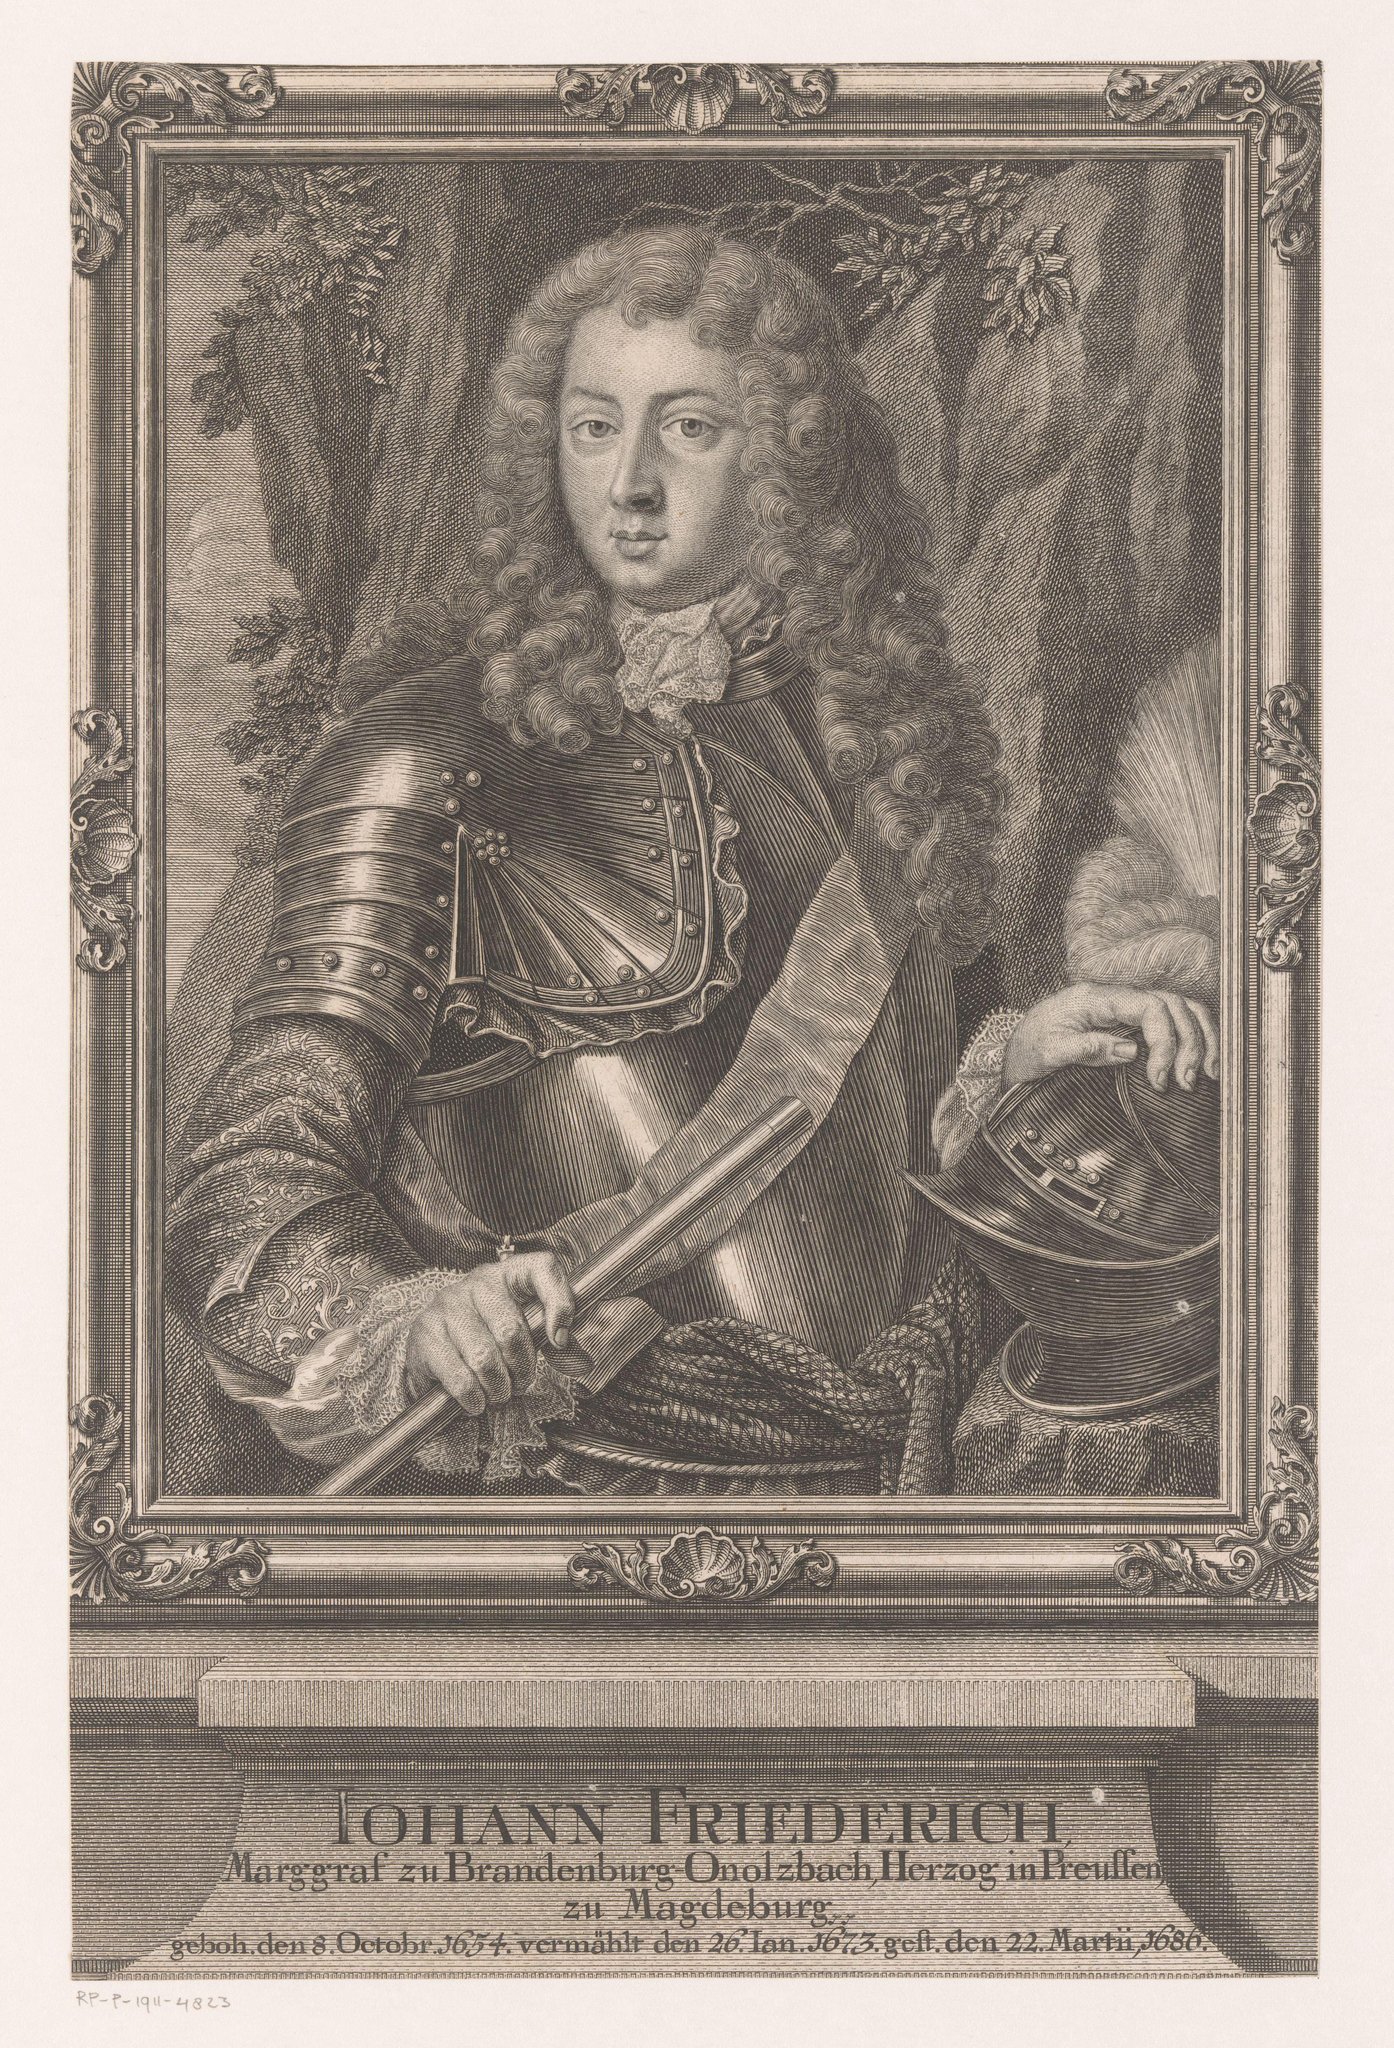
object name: print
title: Portret van Johan Frederik van Brandenburg-Ansbach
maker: johann wilhelm windter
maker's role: draughtsman, print maker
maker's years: 1696-1765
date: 1740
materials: paper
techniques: engraving, etching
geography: nuremberg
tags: historical persons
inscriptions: collector's mark: Lugt 2228